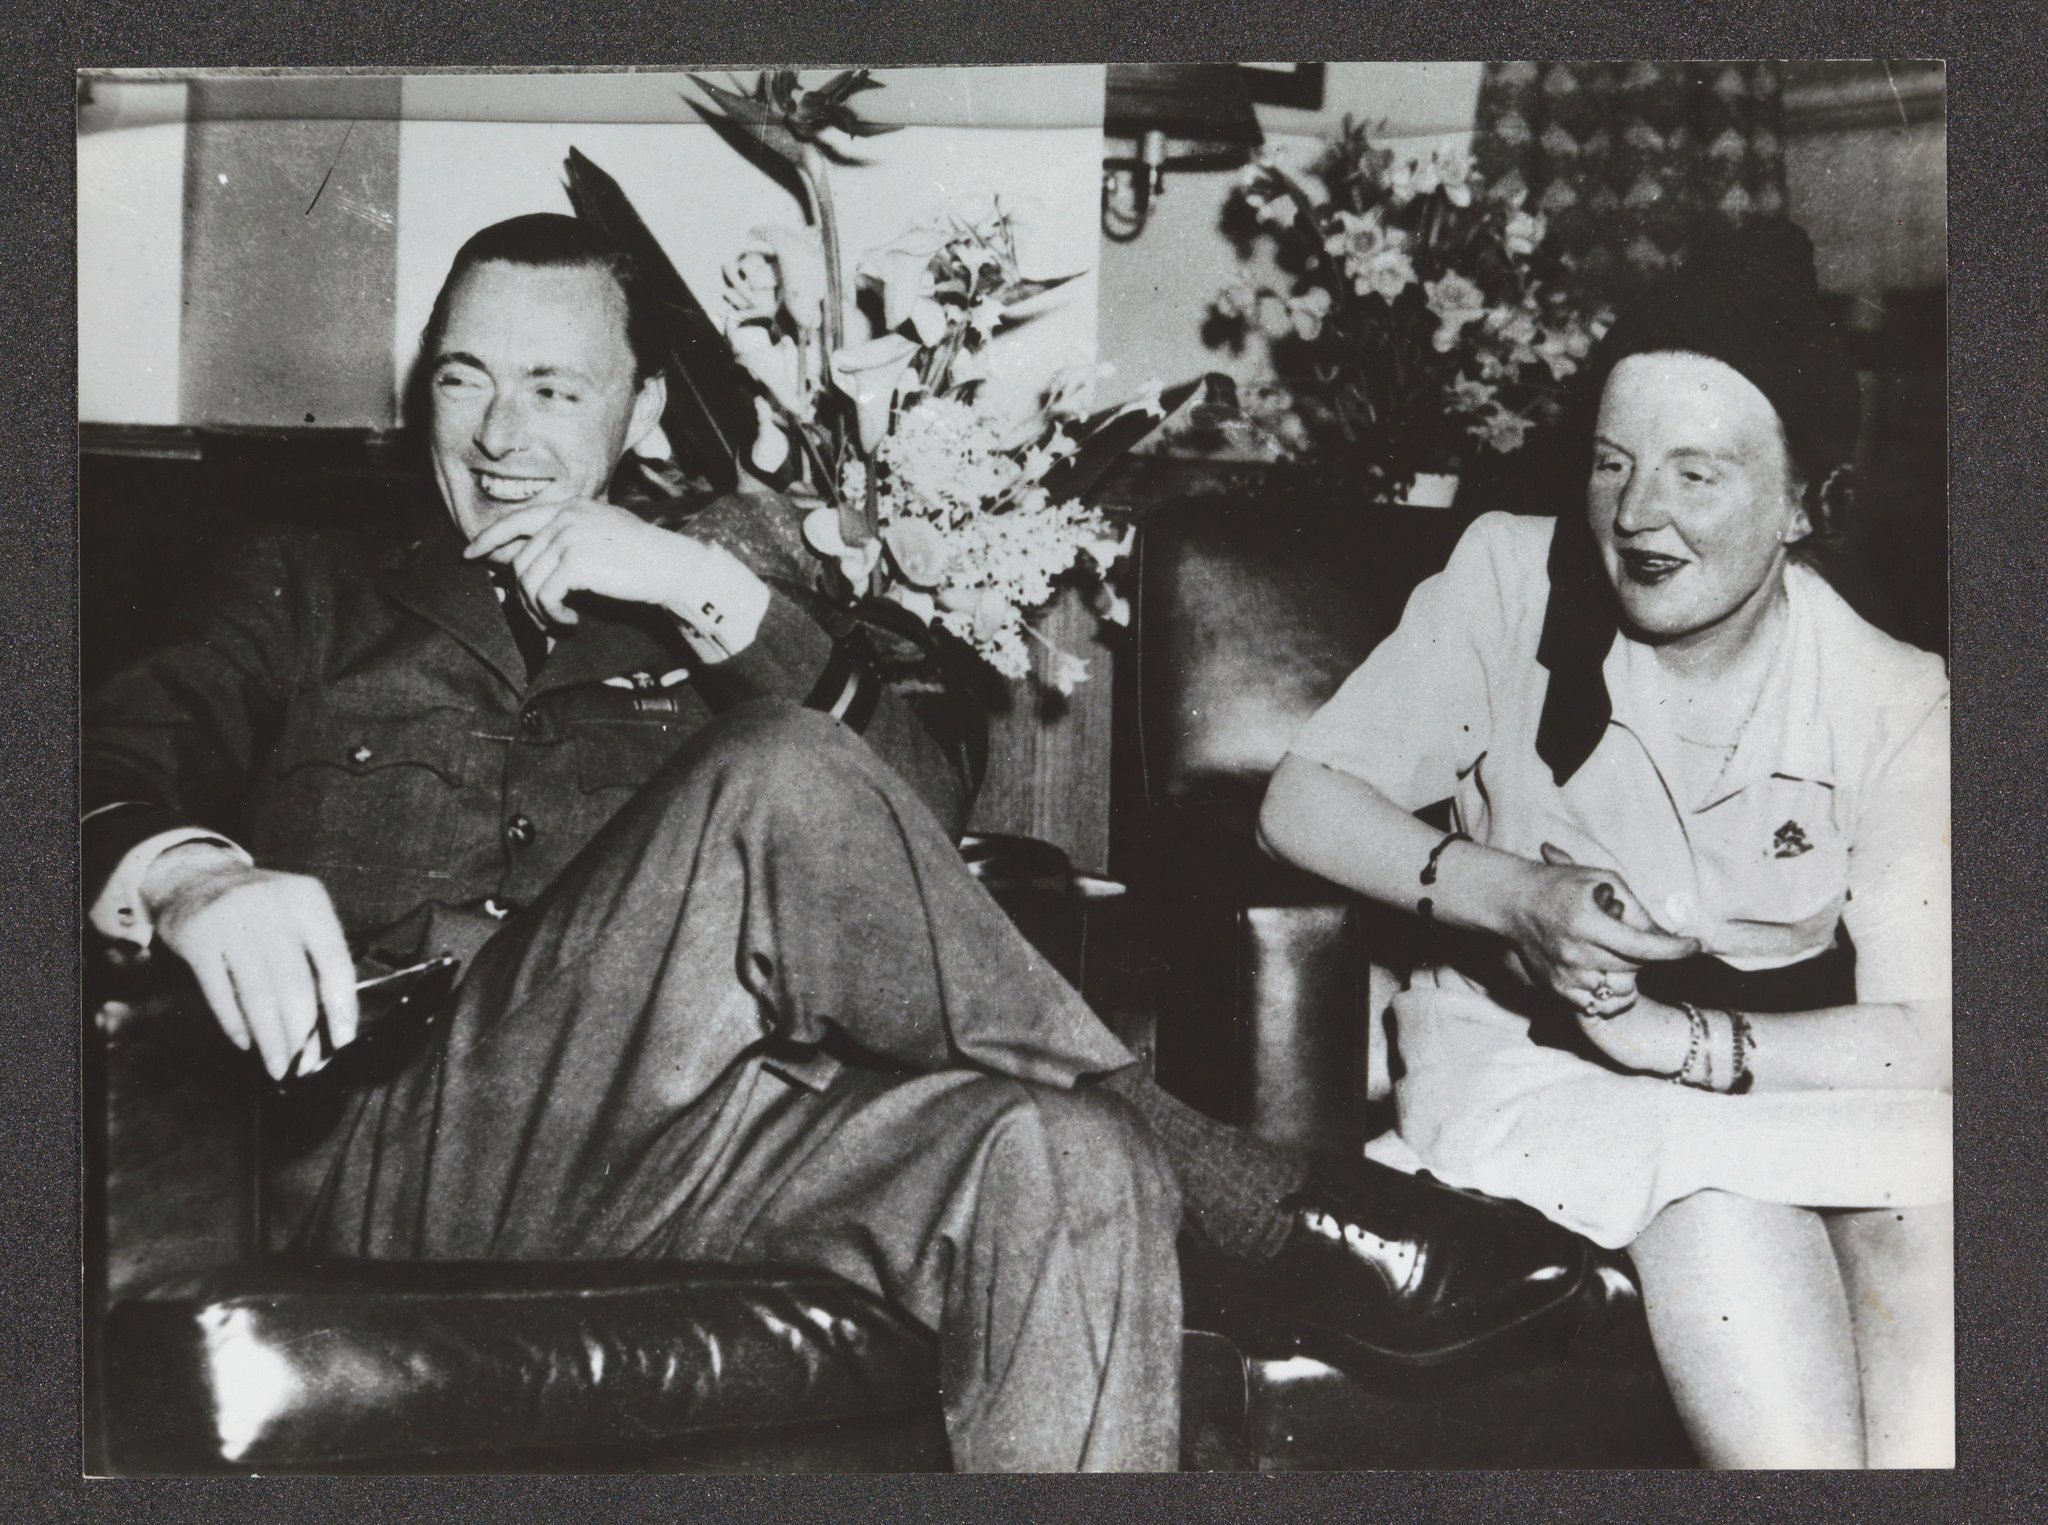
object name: photograph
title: Koningin Juliana en Prins Bernhard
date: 1942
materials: paper, photographic support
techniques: gelatin silver print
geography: netherlands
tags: utrecht, bernhard (prins der nederlanden), juliana of the netherlands, new york (city)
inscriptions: stamp: ‘copyright Anefo Kerkstraat 310 Amsterdam-C PRF -26’